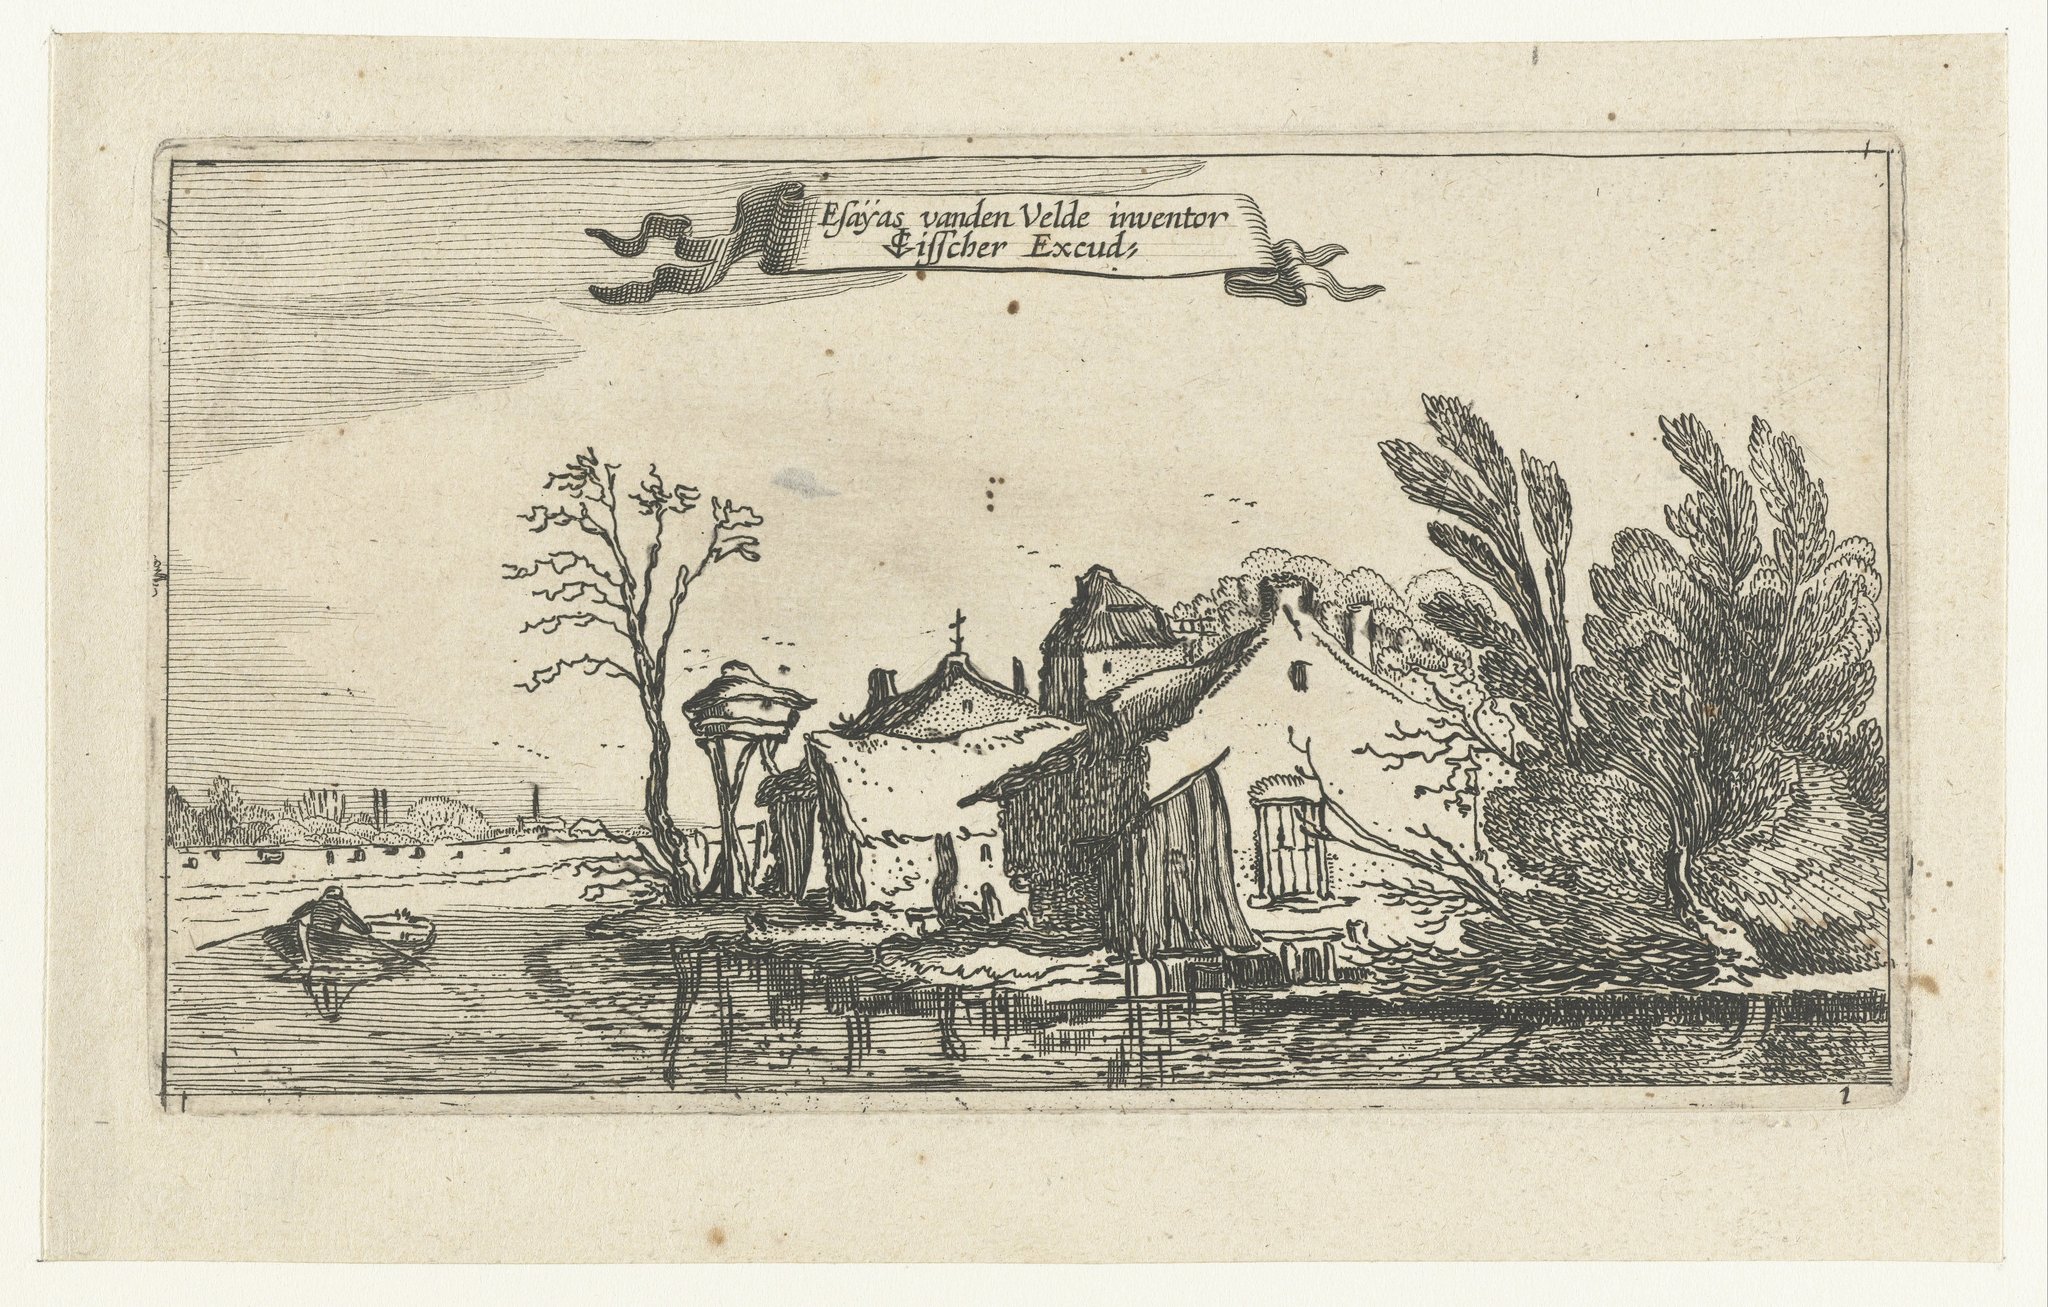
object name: print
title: Landschappen naar Esaias van de Velde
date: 1610-1650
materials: paper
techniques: engraving, etching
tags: river, farm or solitary house in landscape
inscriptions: collector's mark: Lugt 240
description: Tekening van Esaias van de Velde in Darmstadt, zie Keyes 1984, cat.nr. D 105, pl. 15